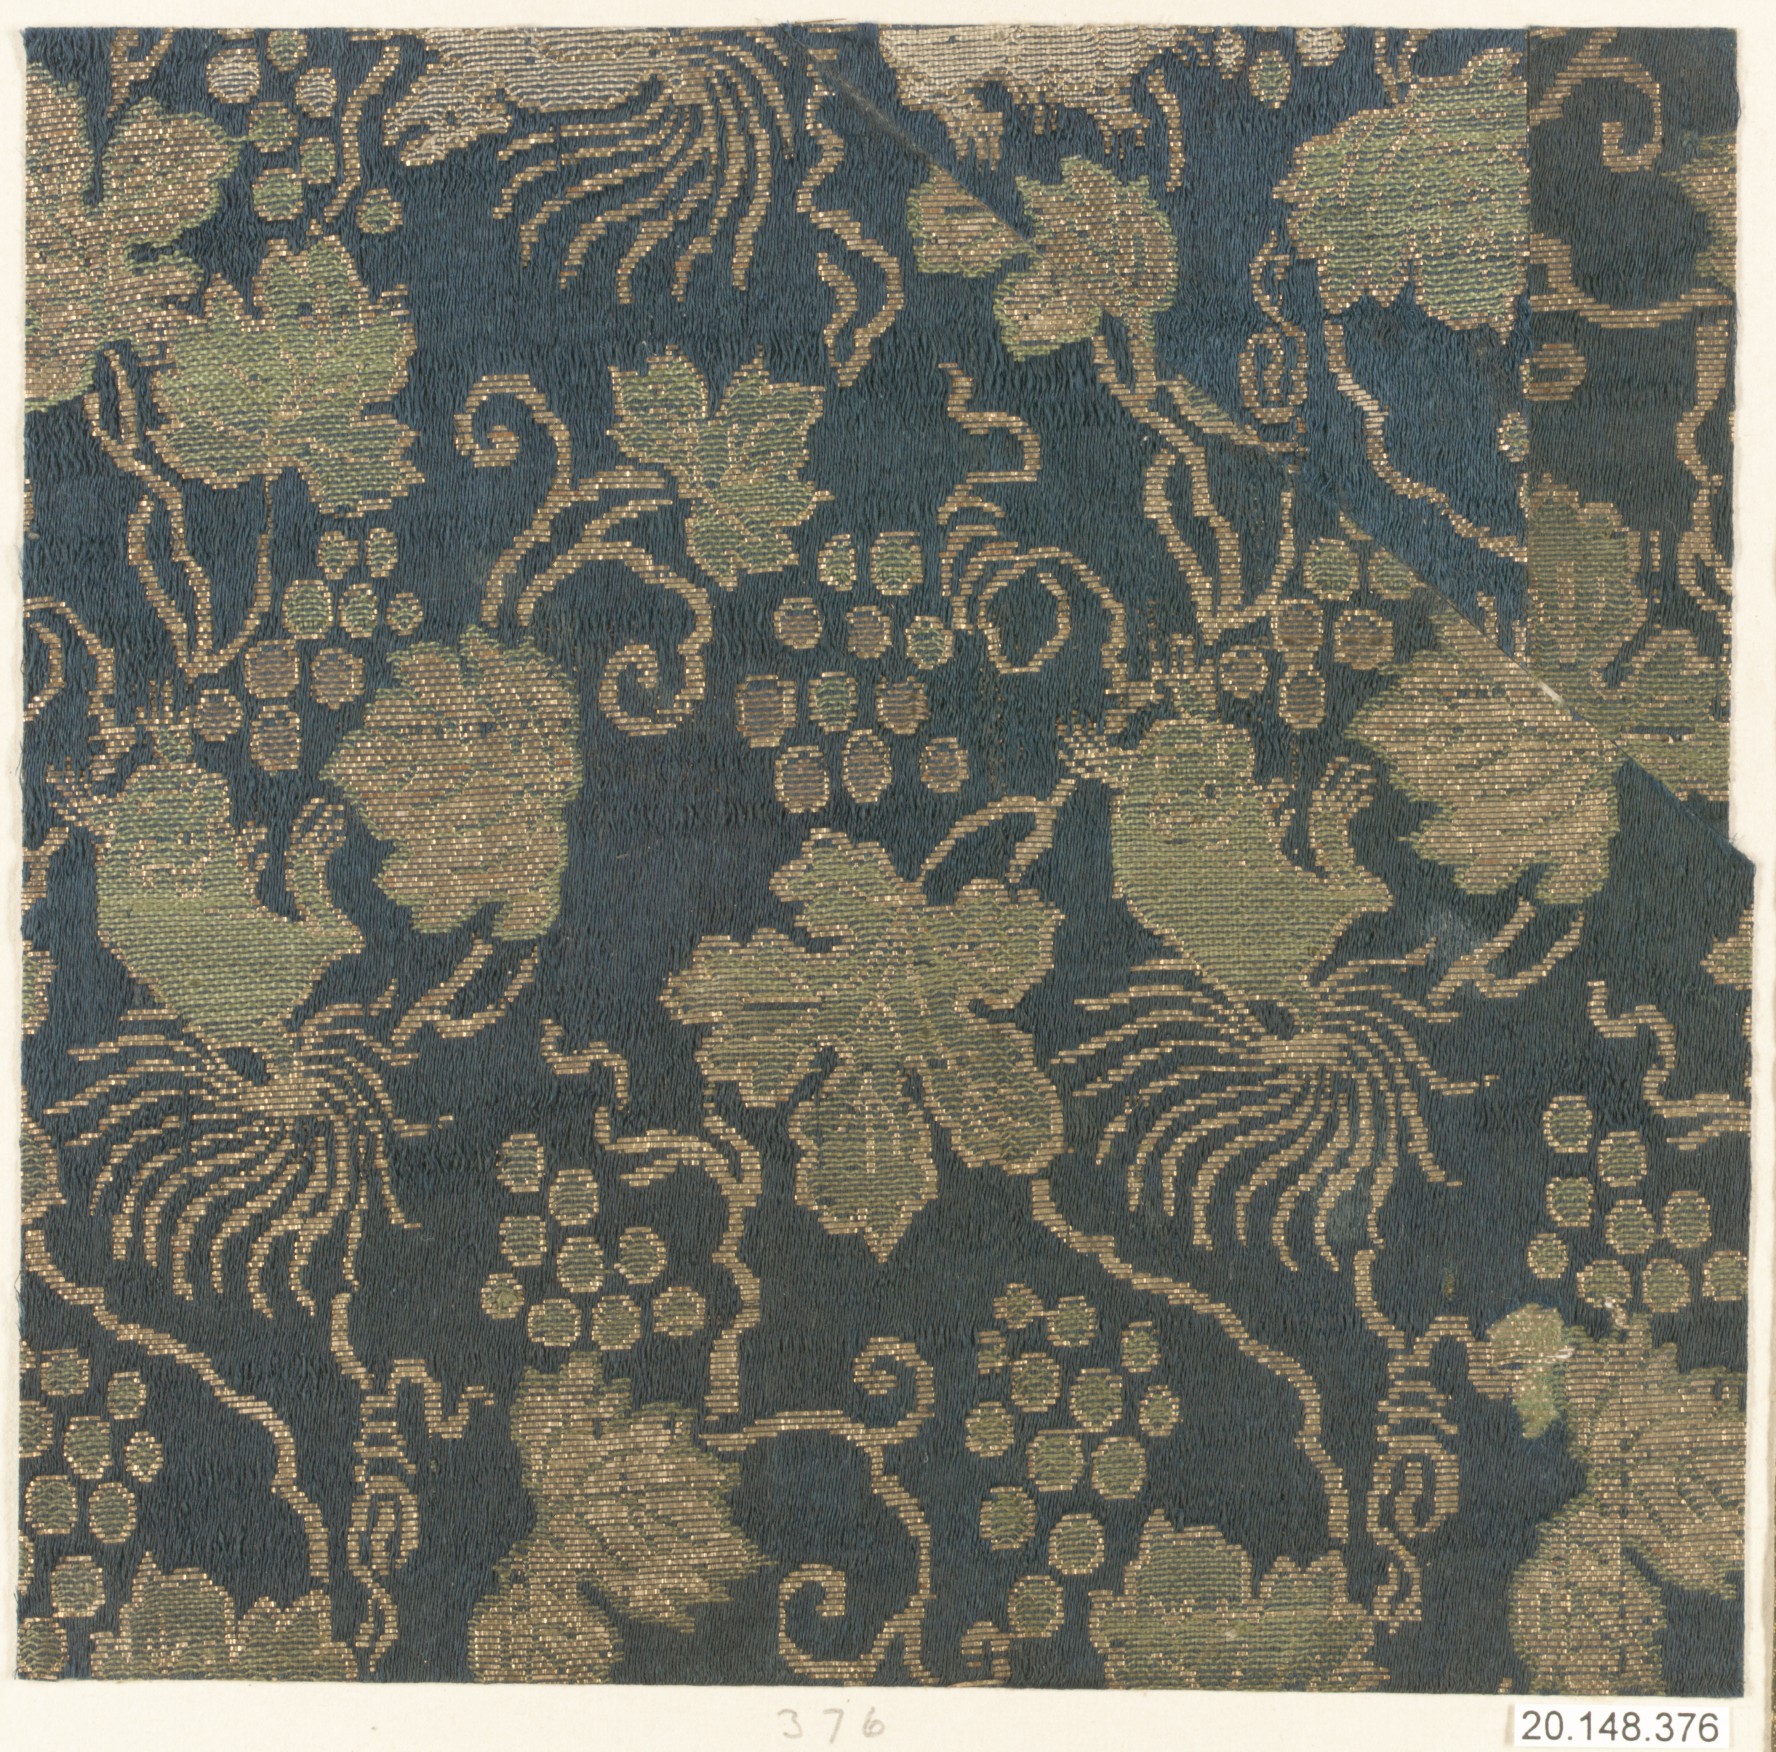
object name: piece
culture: japanese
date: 1701-1800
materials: silk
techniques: compound weave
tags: animals,leaves